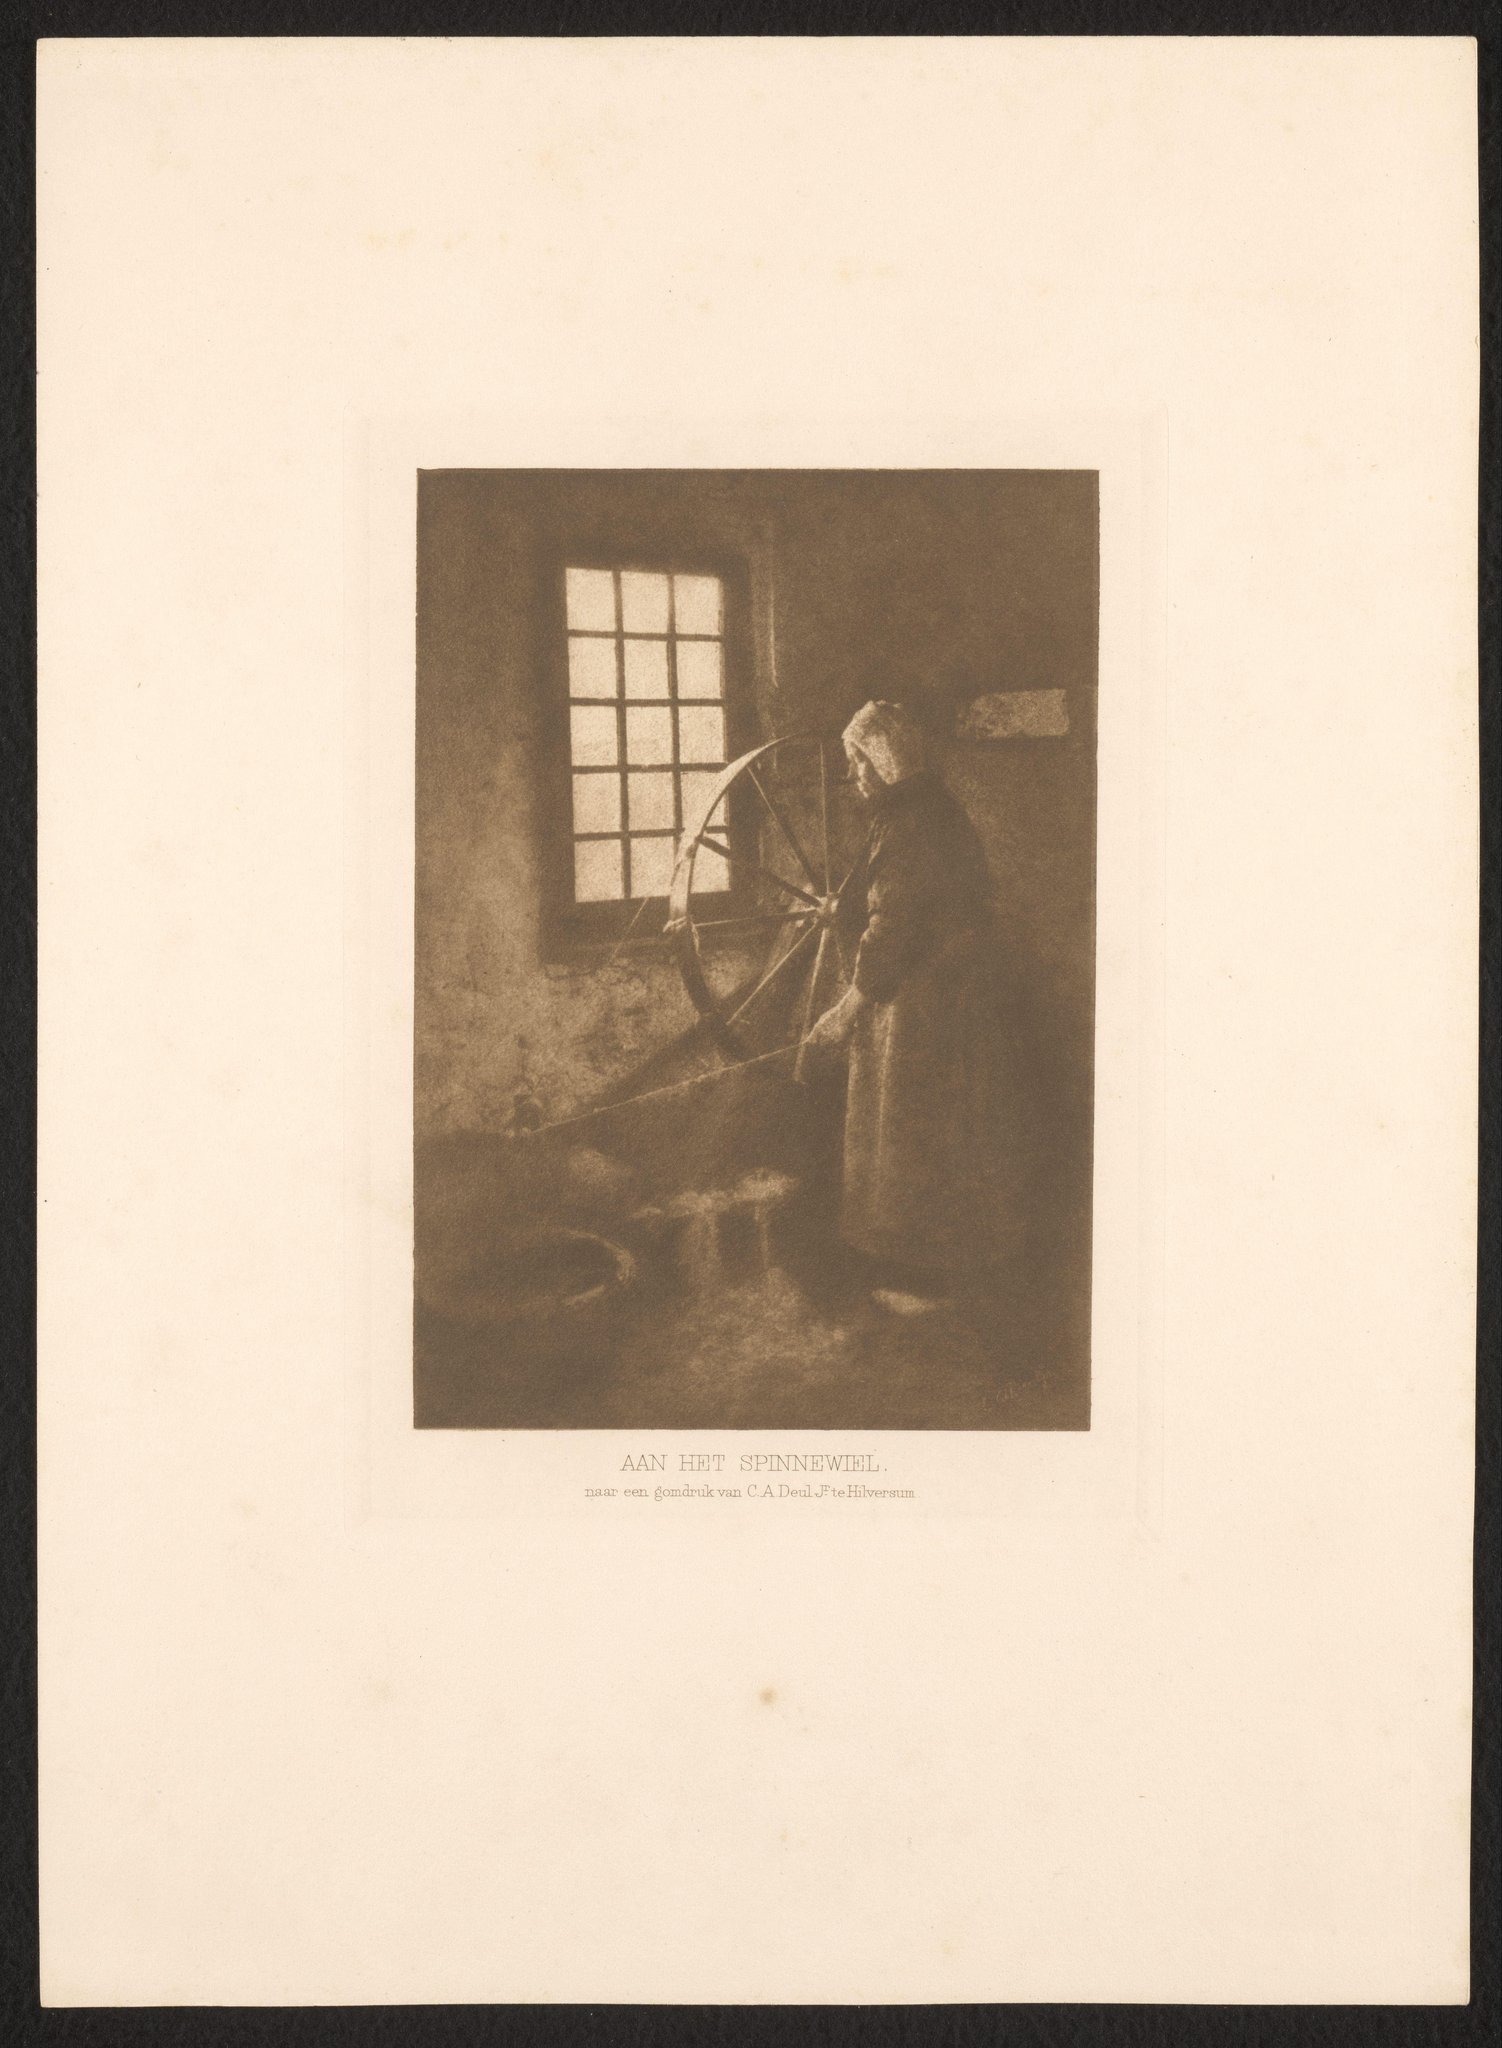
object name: page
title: Vrouw bij een spinnewiel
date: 1900-1905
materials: paper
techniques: photoaquatint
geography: netherlands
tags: female sex; woman, farmers - aa - female farmer, farmer's wife, spinning-wheel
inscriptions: inscription: ‘naar een gomdruk van C.A. Deul Jr. te Hilversum.’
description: Titelblad met ondertitel ontbreekt feitelijk: ondertitel zal gelijk zijn eerste, tweede, derde en vijfde serie